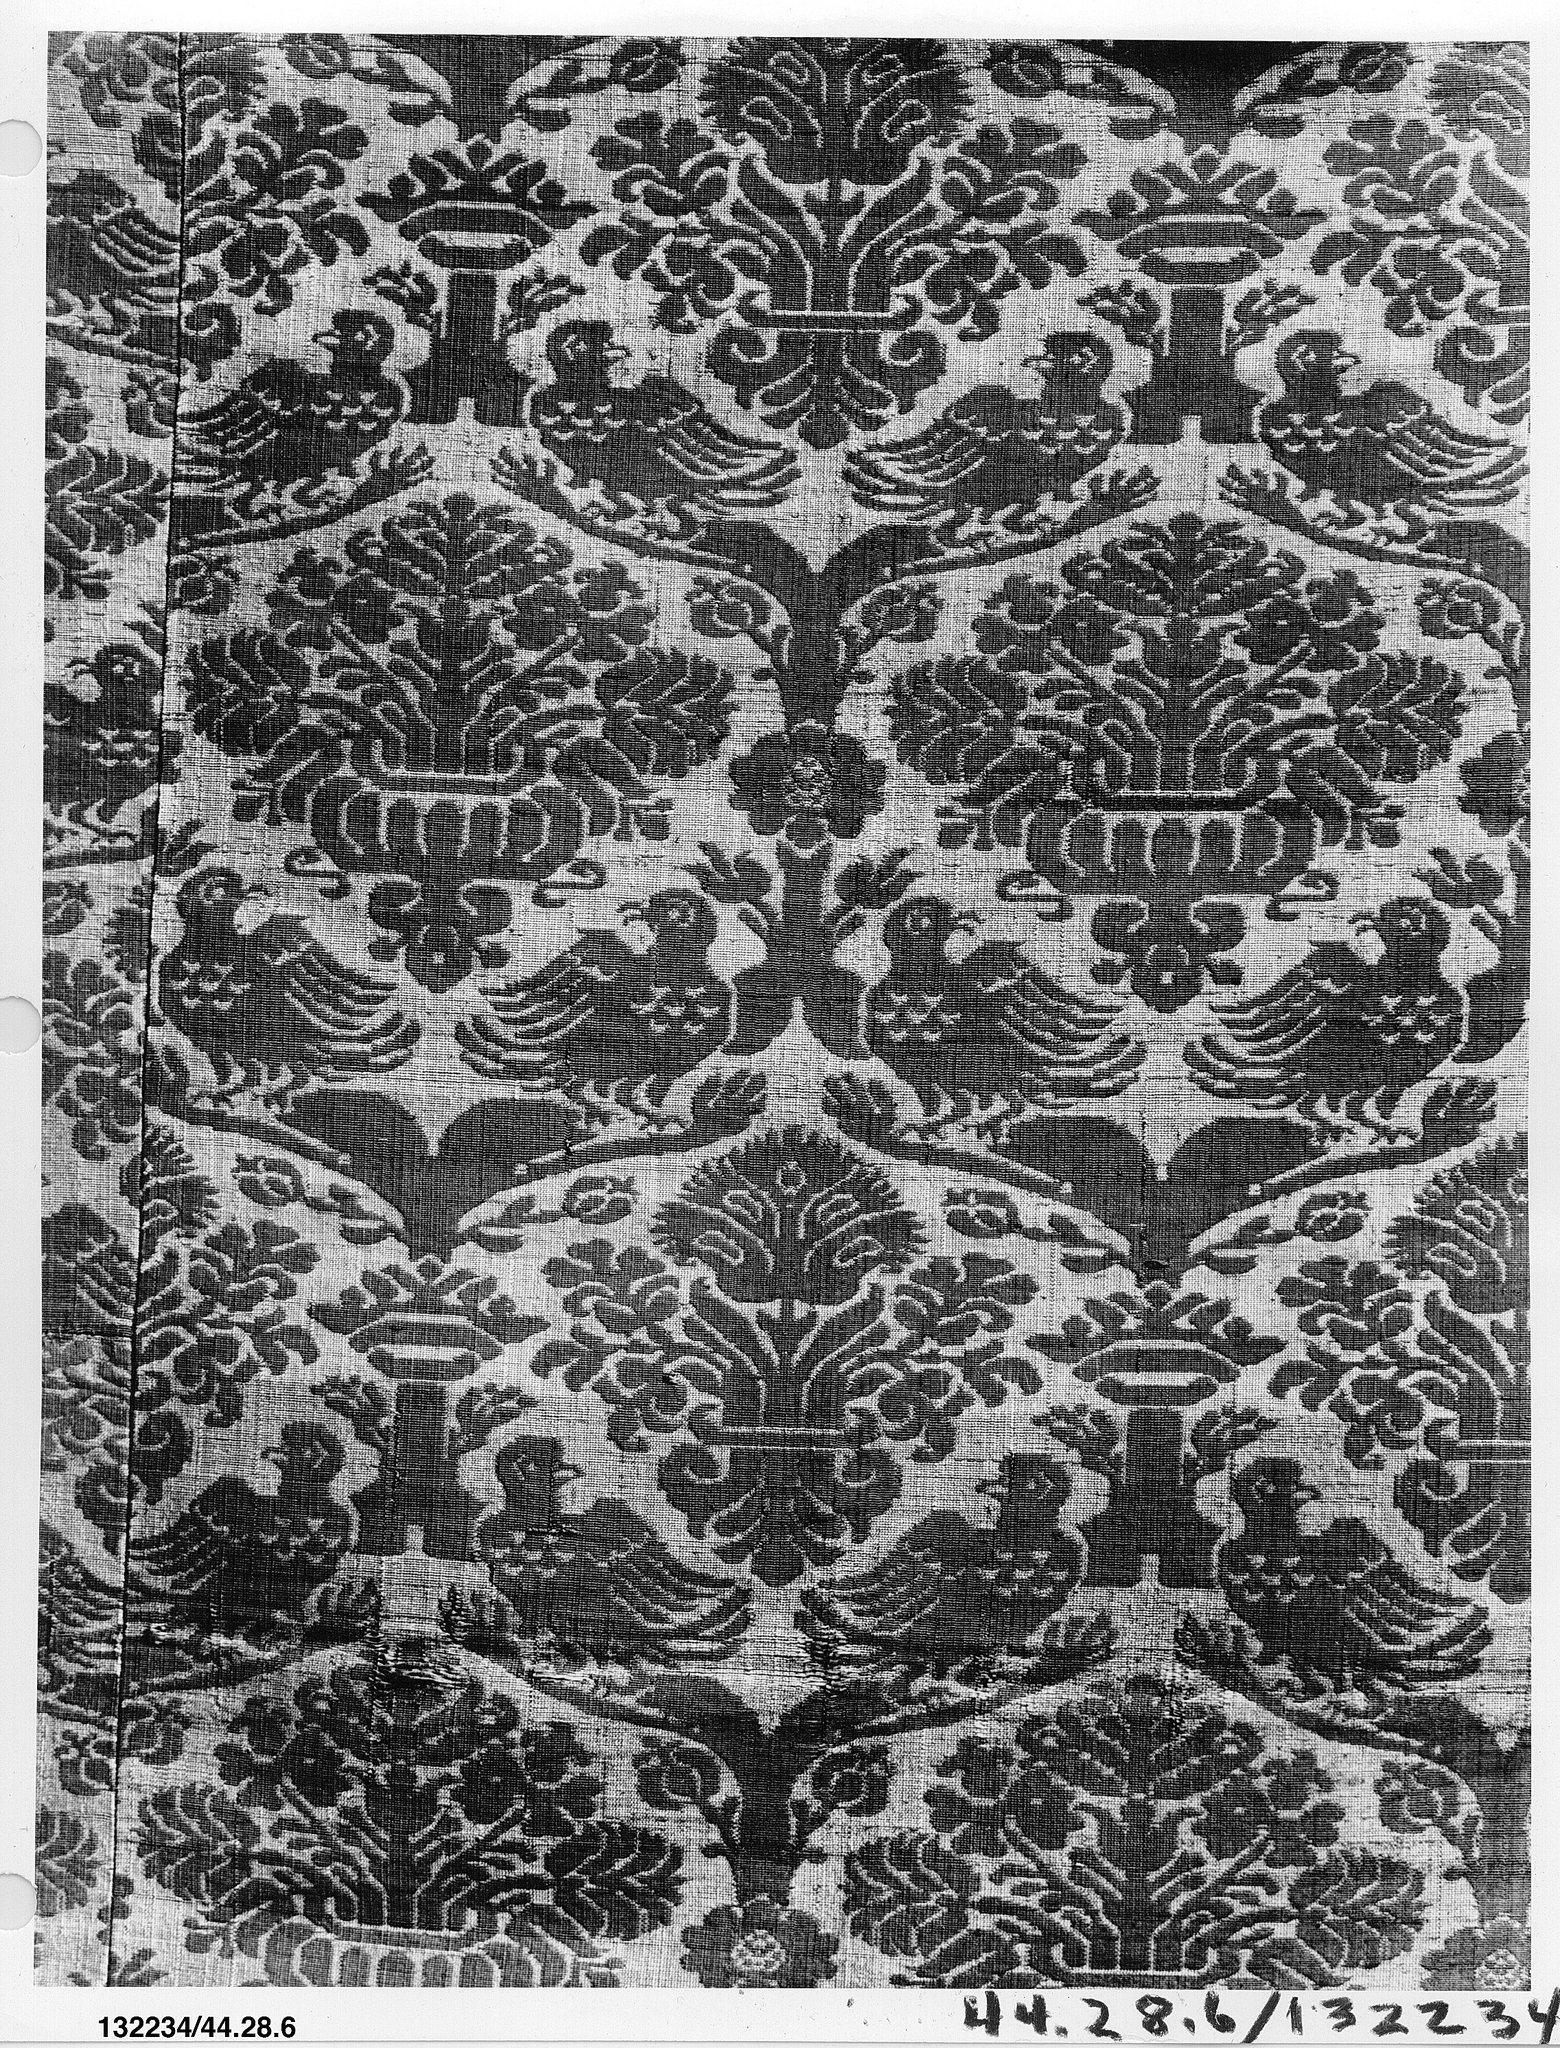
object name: piece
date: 1501-1600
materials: metal thread, silk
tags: birds,flowers